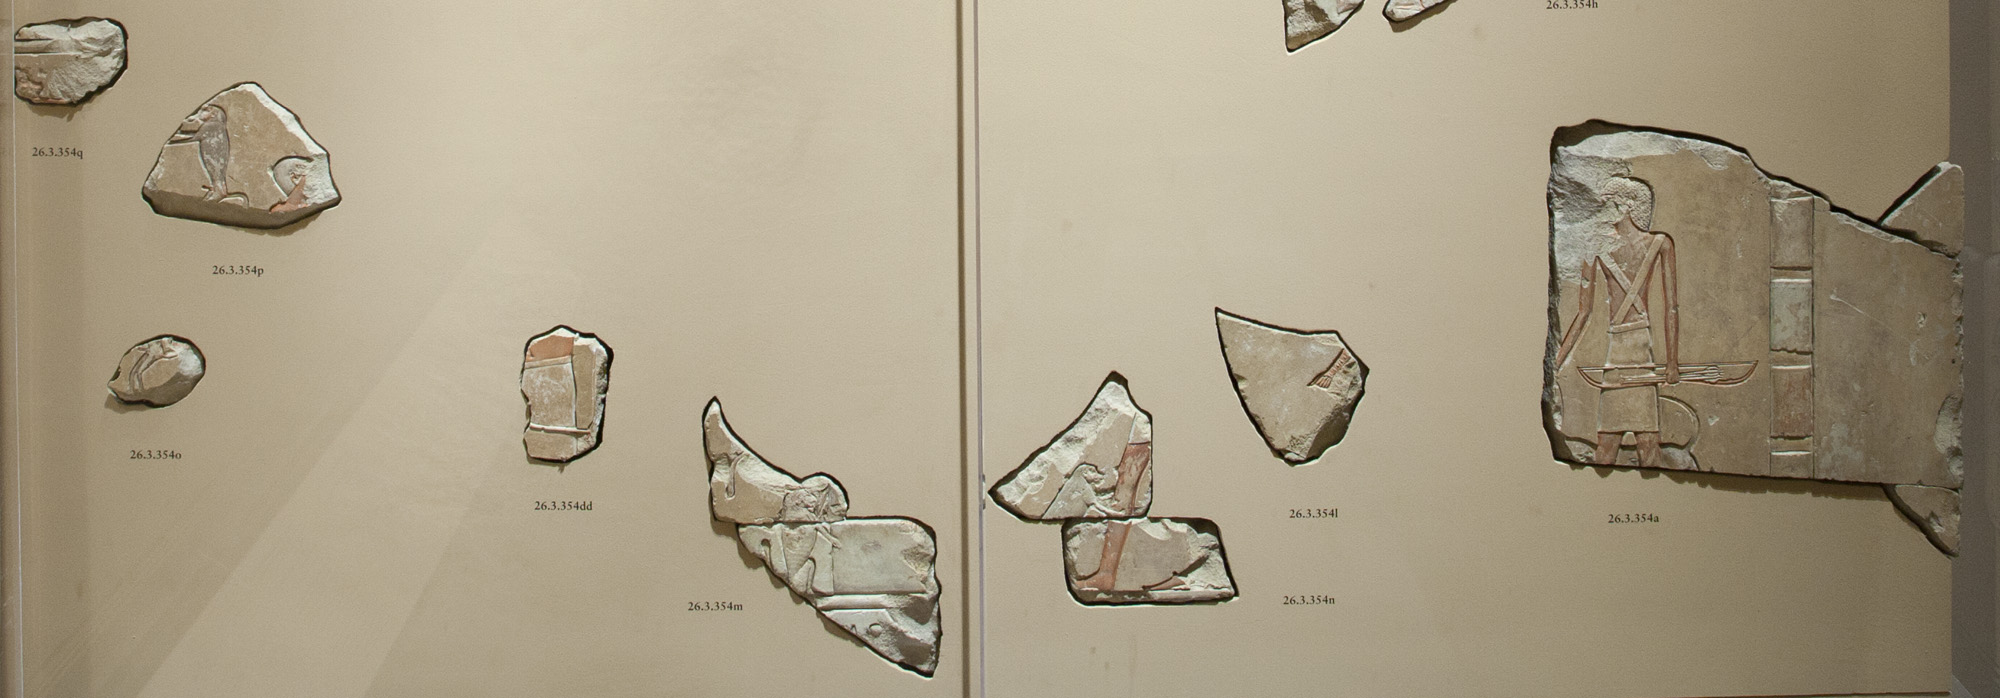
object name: relief, tomb of khety, monkey, baboon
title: Scene with monkeys and baboons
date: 2051-2000 BCE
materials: limestone, paint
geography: egypt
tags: monkeys